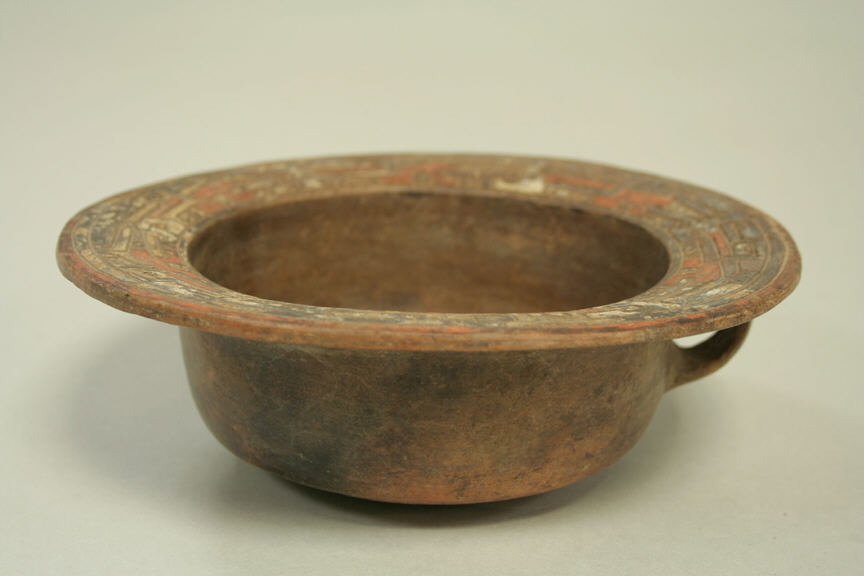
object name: bowl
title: Bowl with Flat Rim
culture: paracas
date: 500-201 BCE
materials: ceramic, pigment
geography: peru